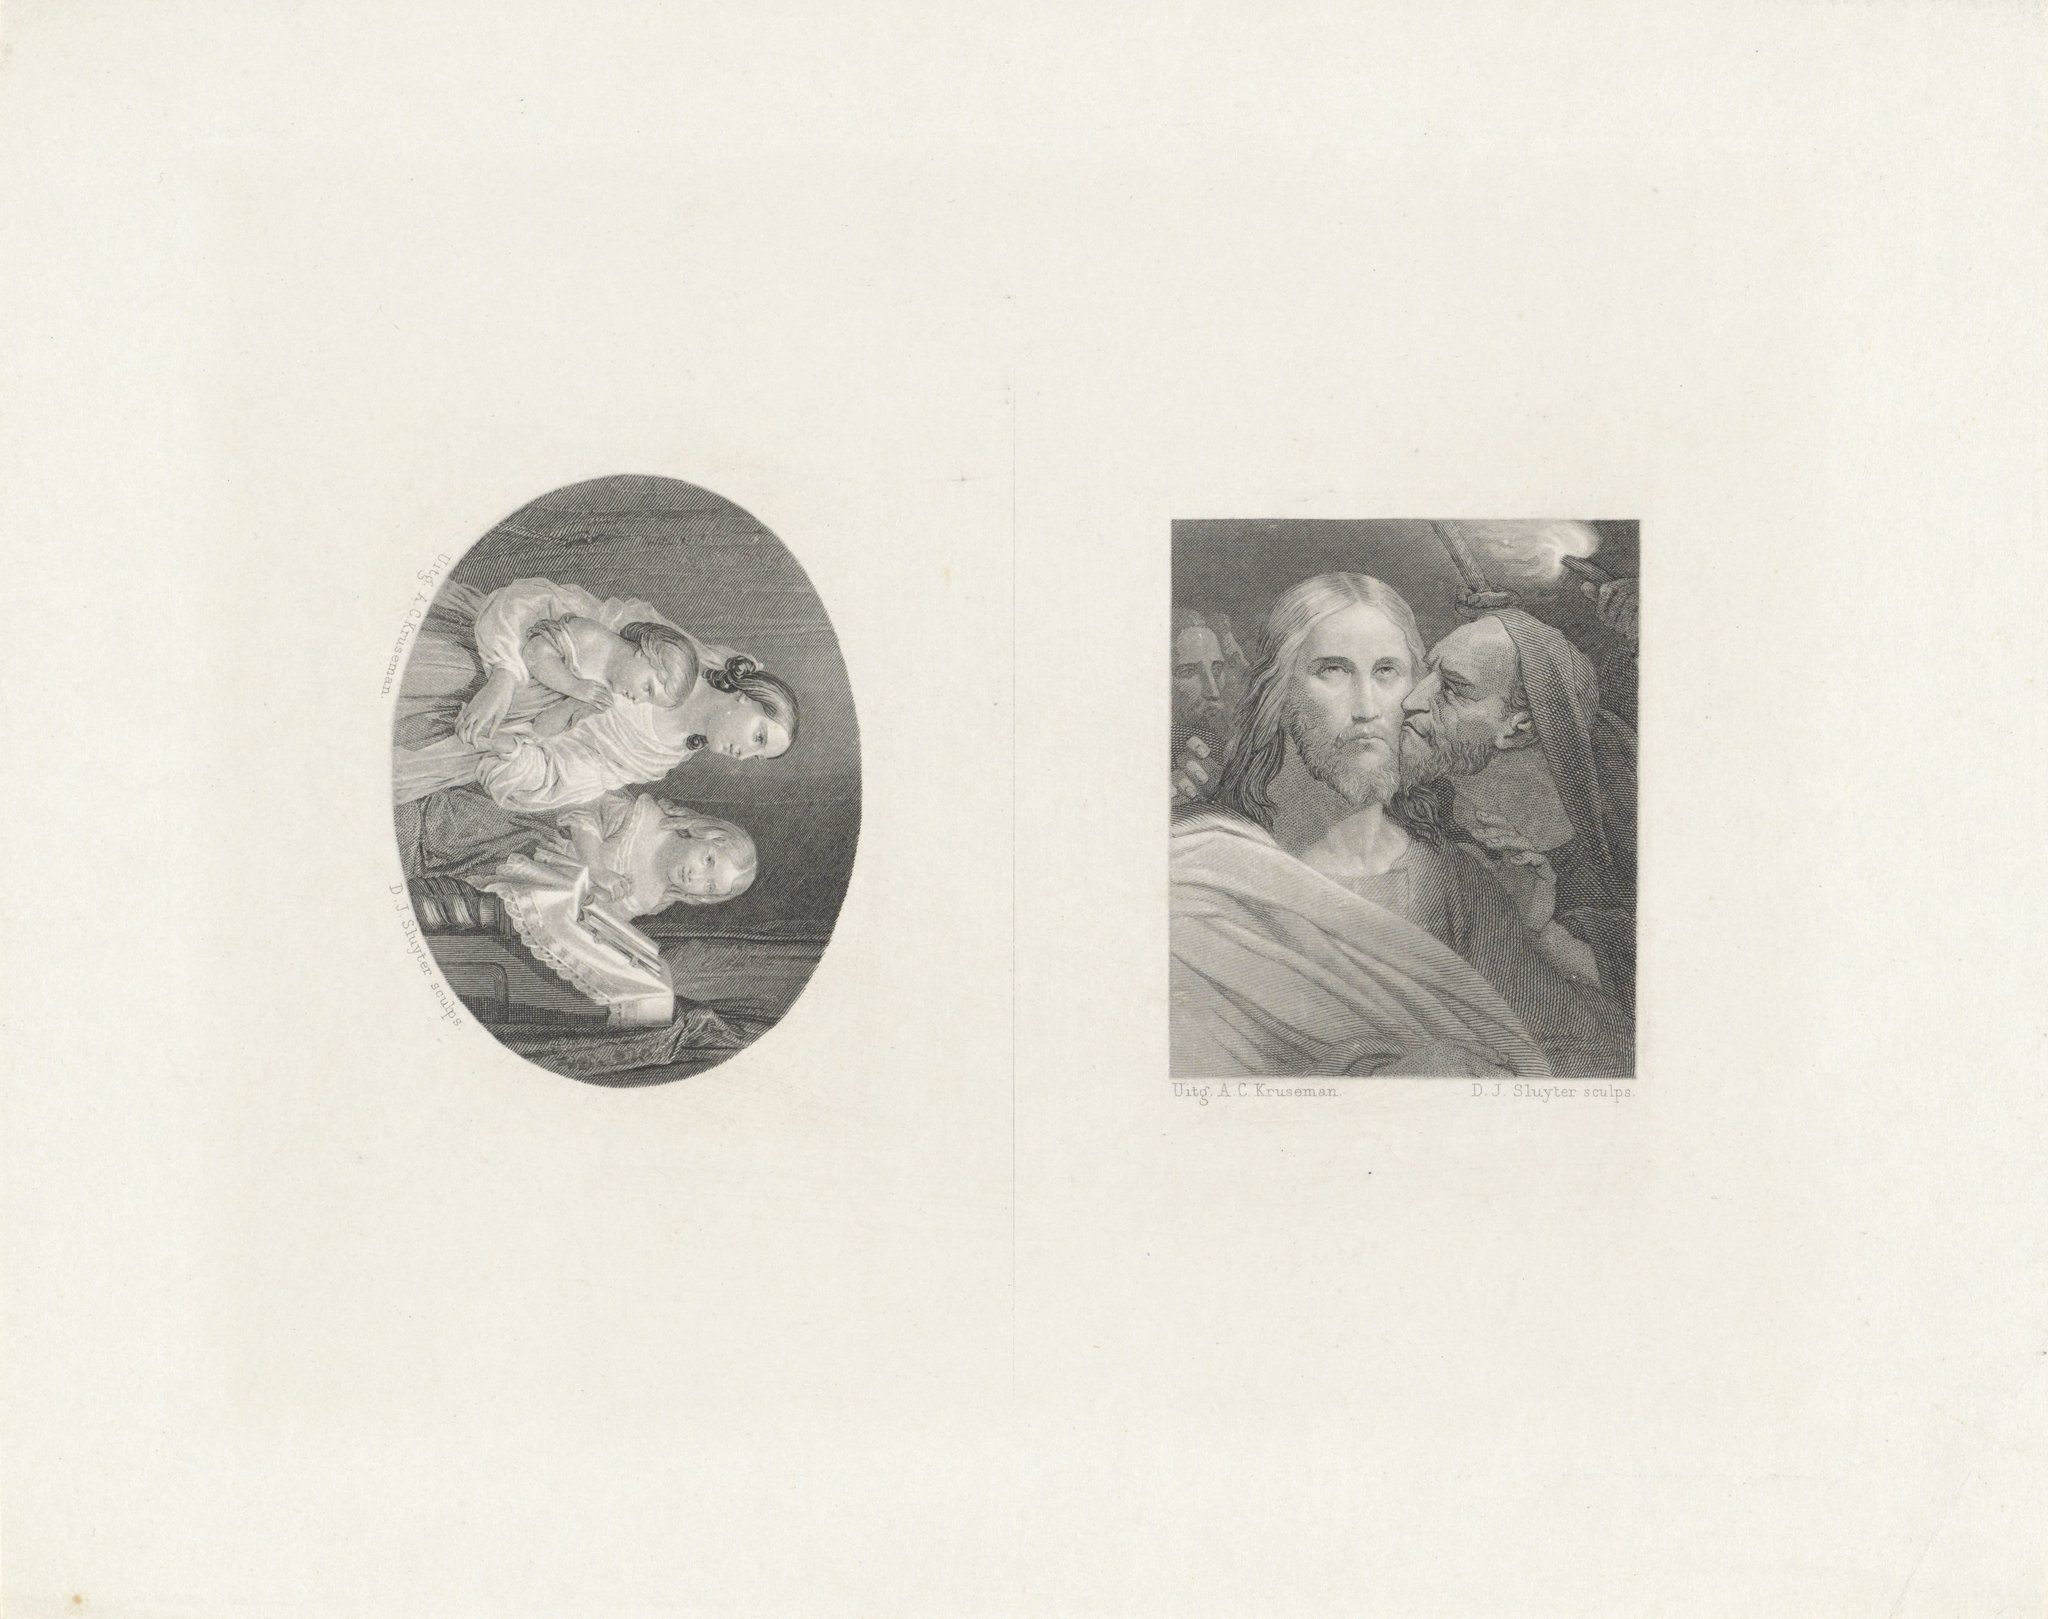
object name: print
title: Het gebed - De Judas-kus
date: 1842-1873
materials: paper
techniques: aquatint, etching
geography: amsterdam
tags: the kiss of judas: accompanied by soldiers with torches and lanterns, he kisses christ, girl (child between toddler and youth), (private) prayer; 'oratione', 'preghiere', 'preghiere a dio' (ripa)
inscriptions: collector's mark: Lugt 2228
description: Twee boekillustraties op een plaat. Links drie biddende meisjes voor een boek op een met een kanten doek bekleedde lezenaar. Rechts Judas die de wang van Christus kust.